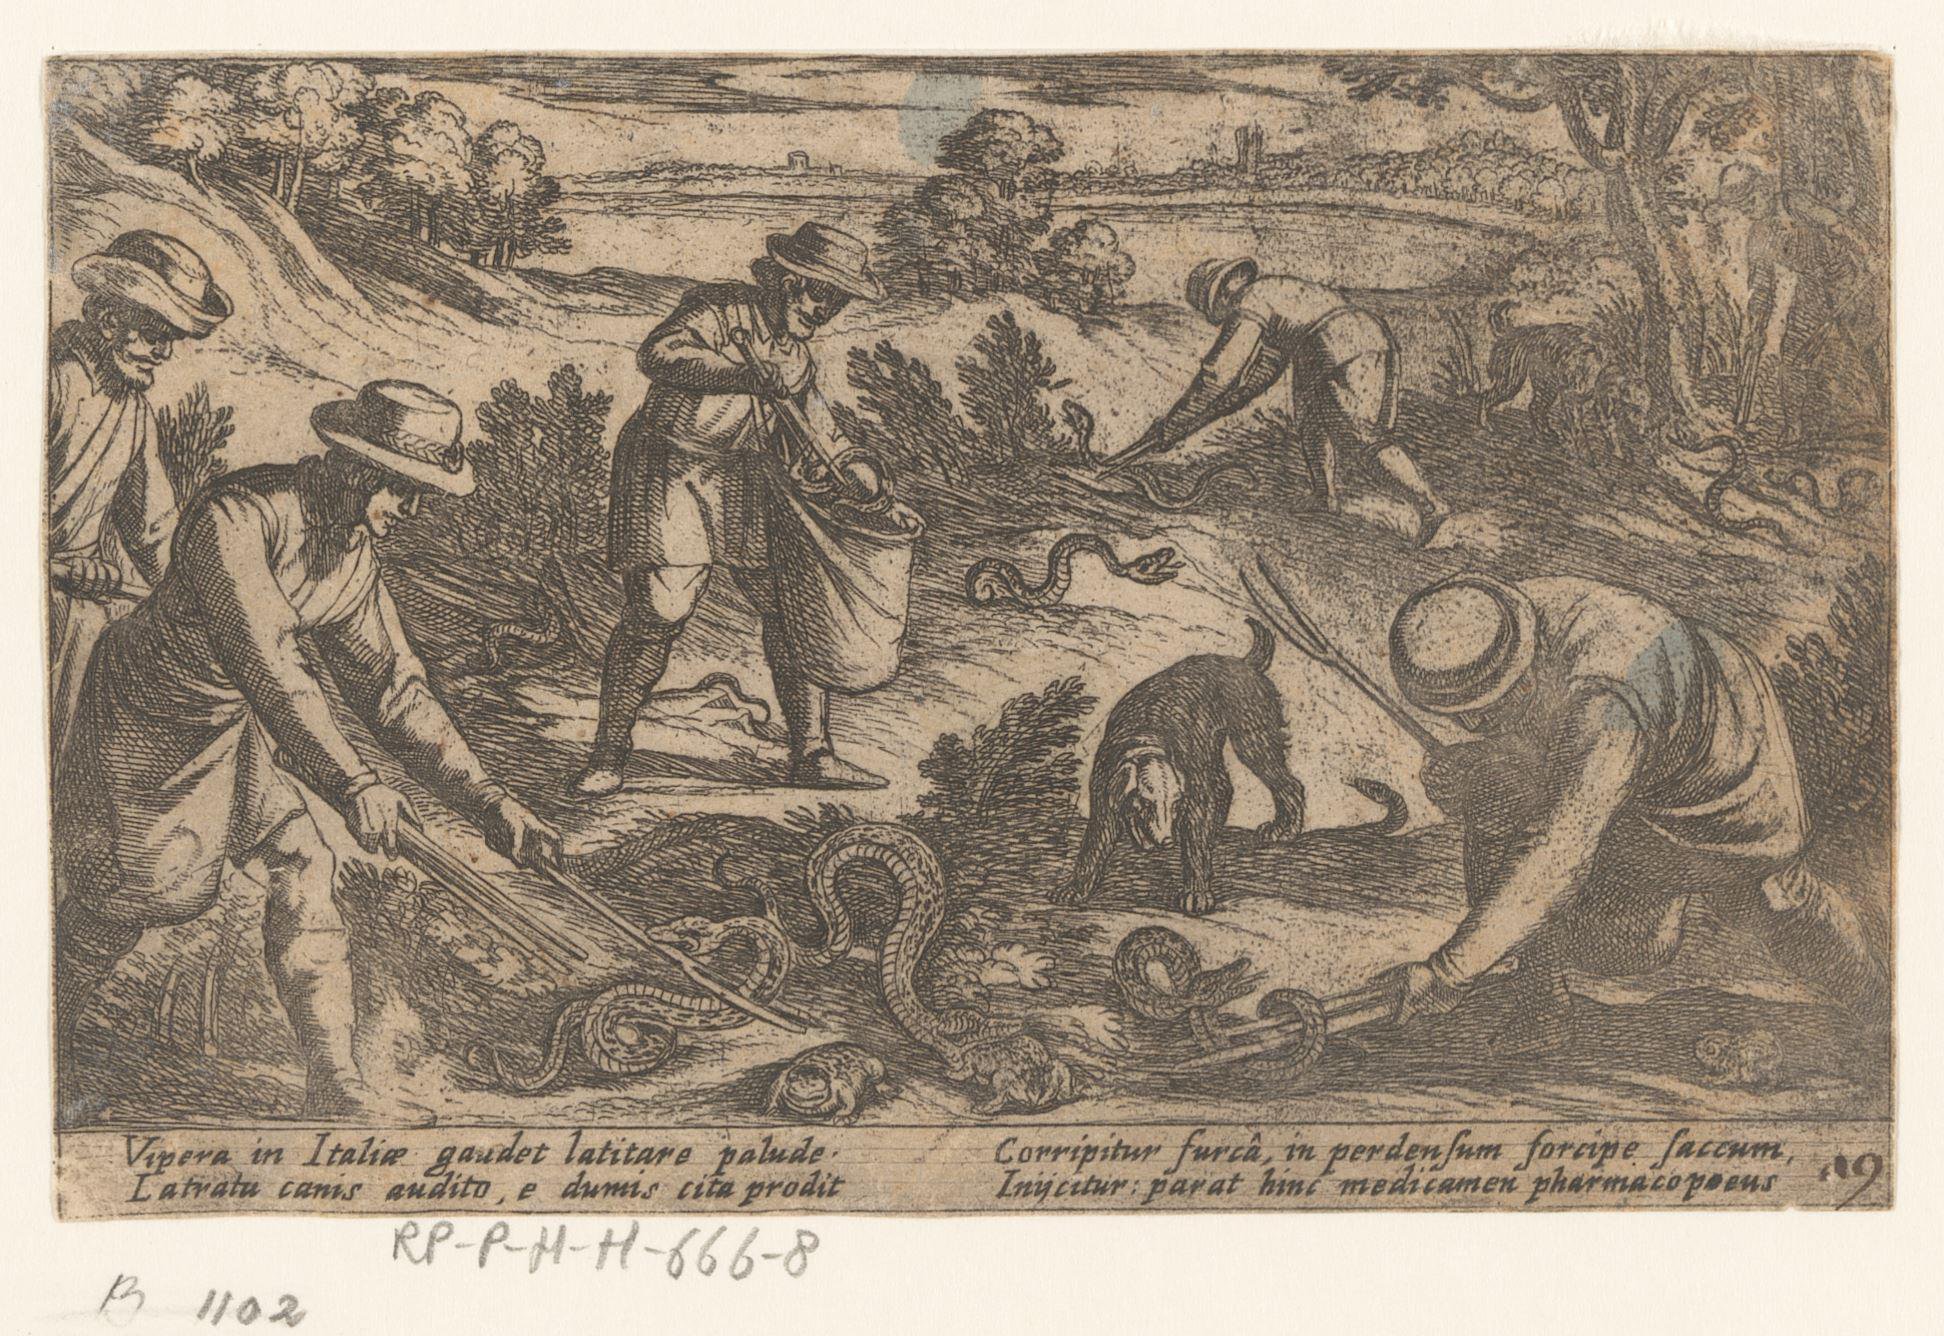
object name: print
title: Jagers vangen slangen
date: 1605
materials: paper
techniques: etching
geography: rome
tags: snakes, hunter, hunters hunting (n.b.: in 1988-1990 this notation denoted the concept of 43c11421 'hunters resting during the hunt')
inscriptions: collector's mark: ‘Hinloopen’, number: ‘19’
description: Landschap met jagers en een hond jagend op slangen. Tekst in het Latijn in ondermarge.